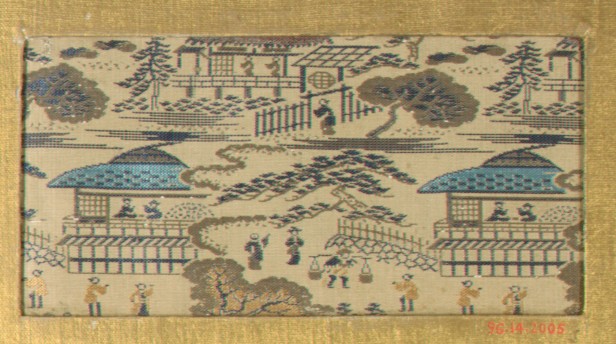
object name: piece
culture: japanese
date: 1701-1900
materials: silk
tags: human figures,buildings